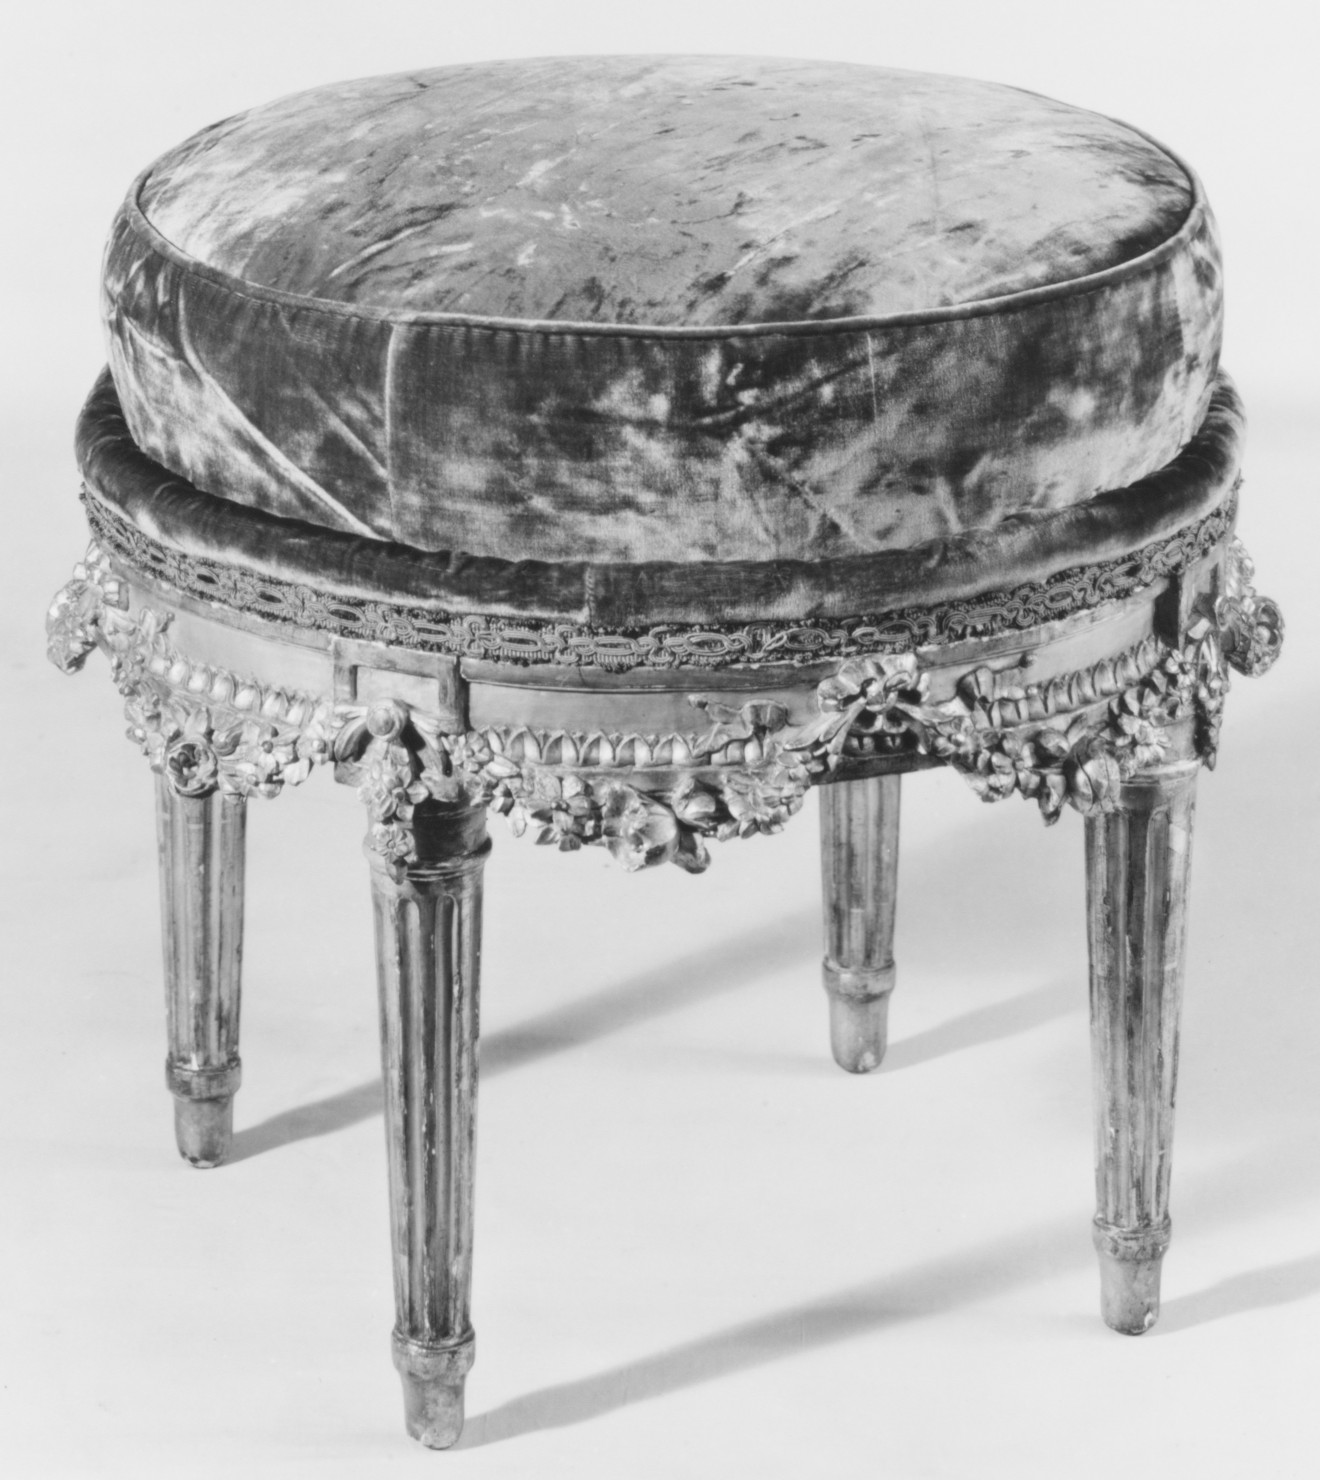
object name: stool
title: Round stool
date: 1780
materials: wood, silk, velvet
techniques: carving, gilding